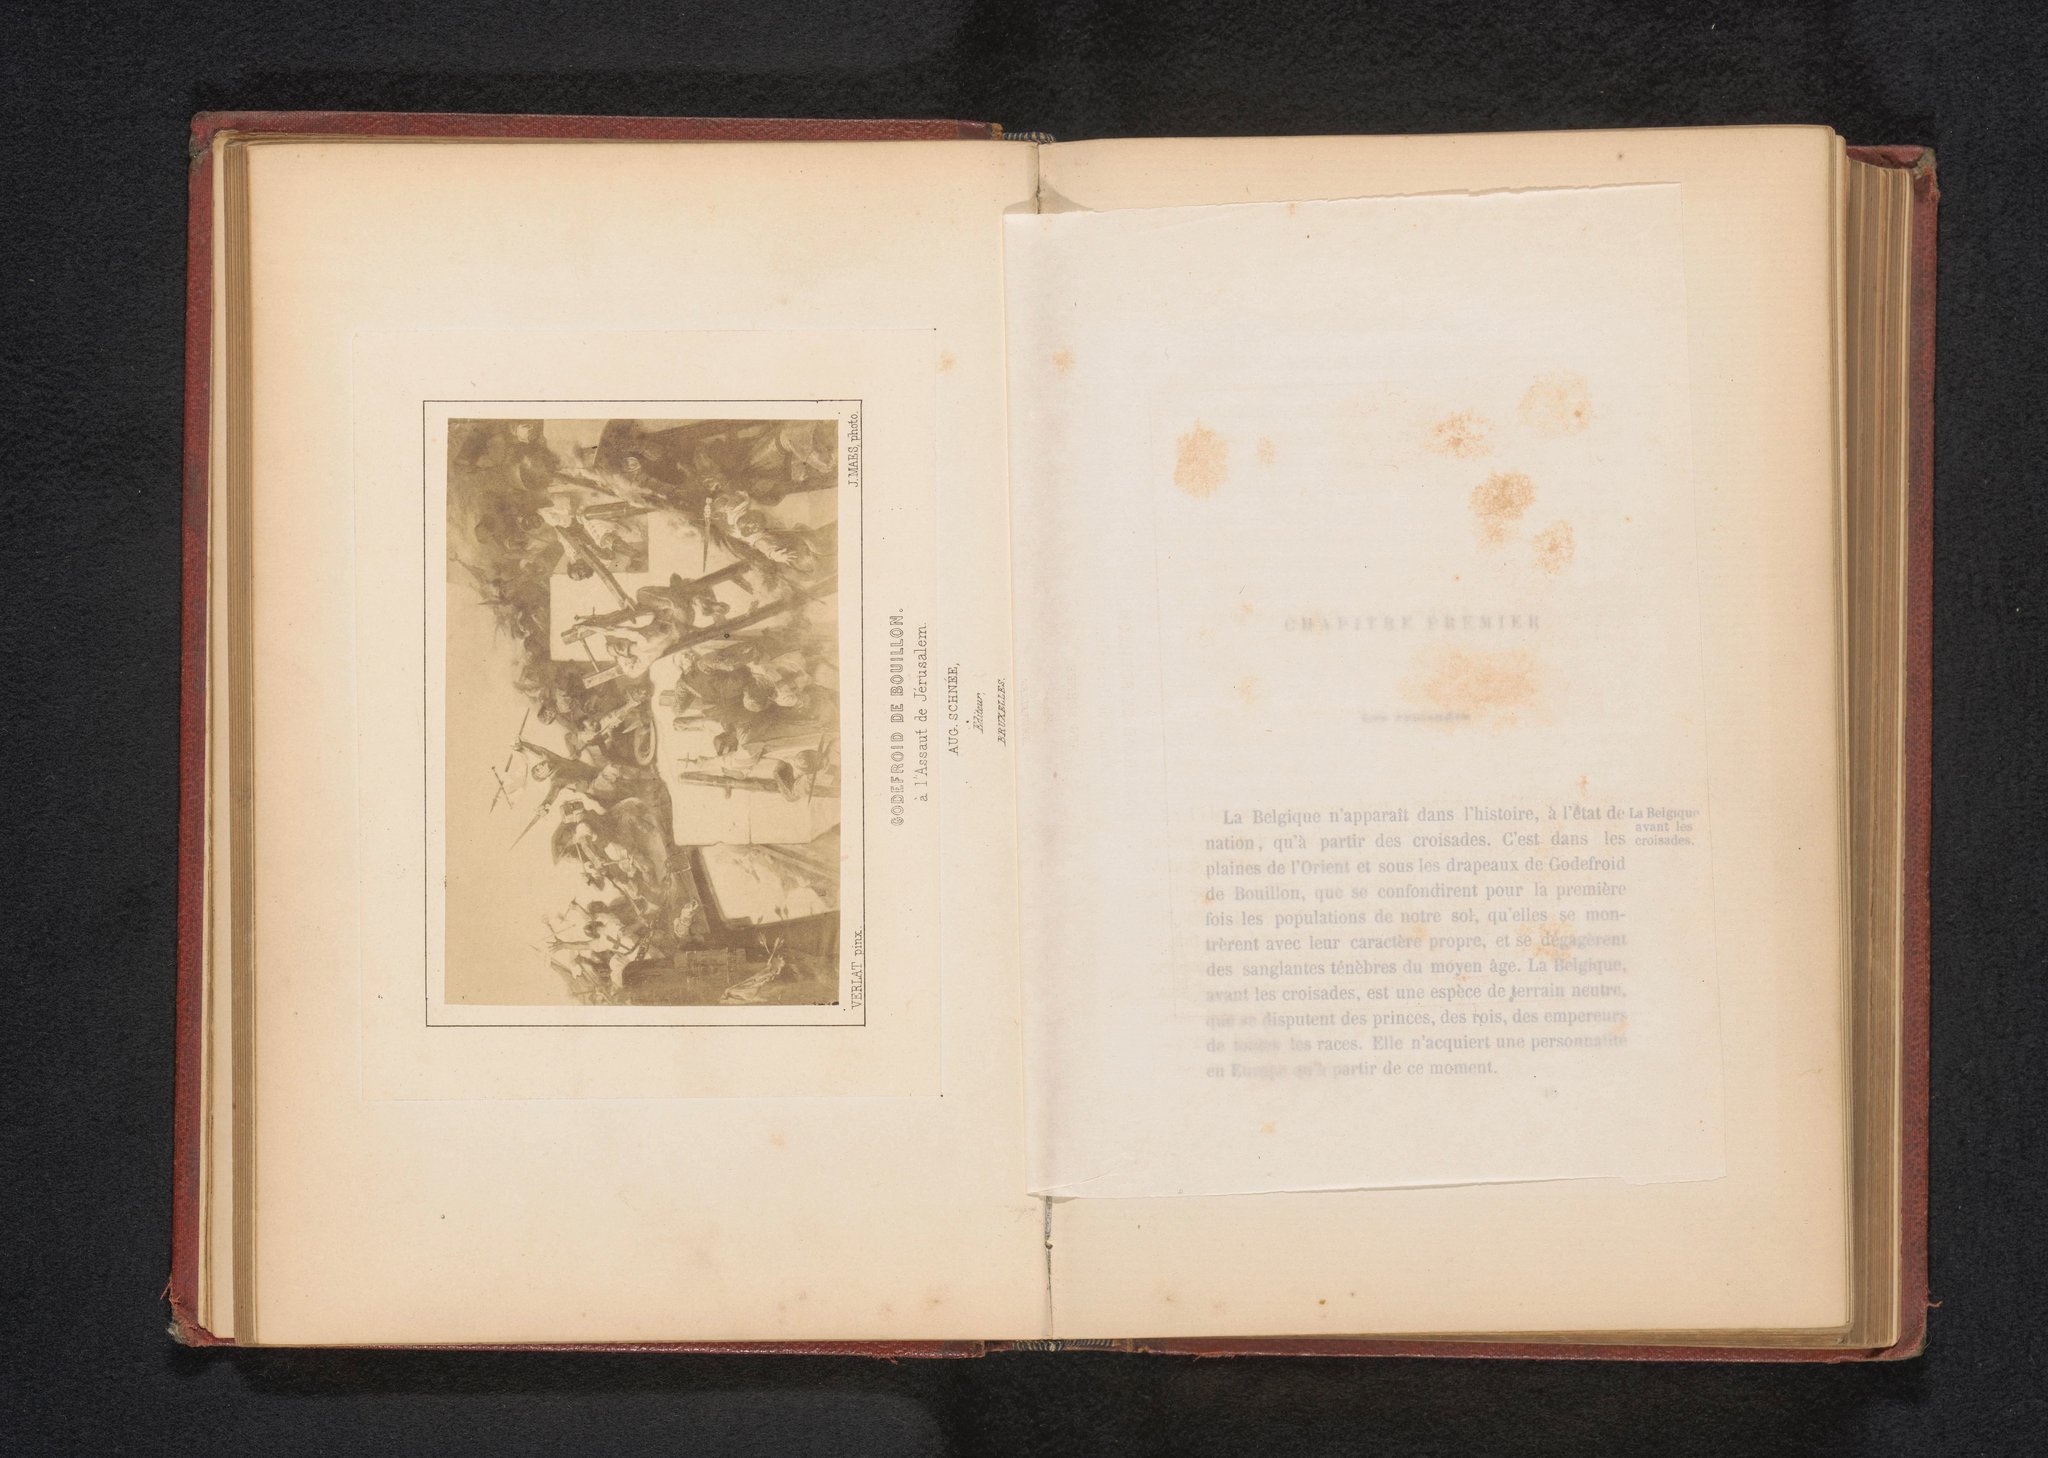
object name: photograph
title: Godefroid de Bouillon à l'Assaut de Jérusalem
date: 1855-1860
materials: photographic support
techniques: albumen print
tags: militant proselytizing: religious war, crusade, etc.